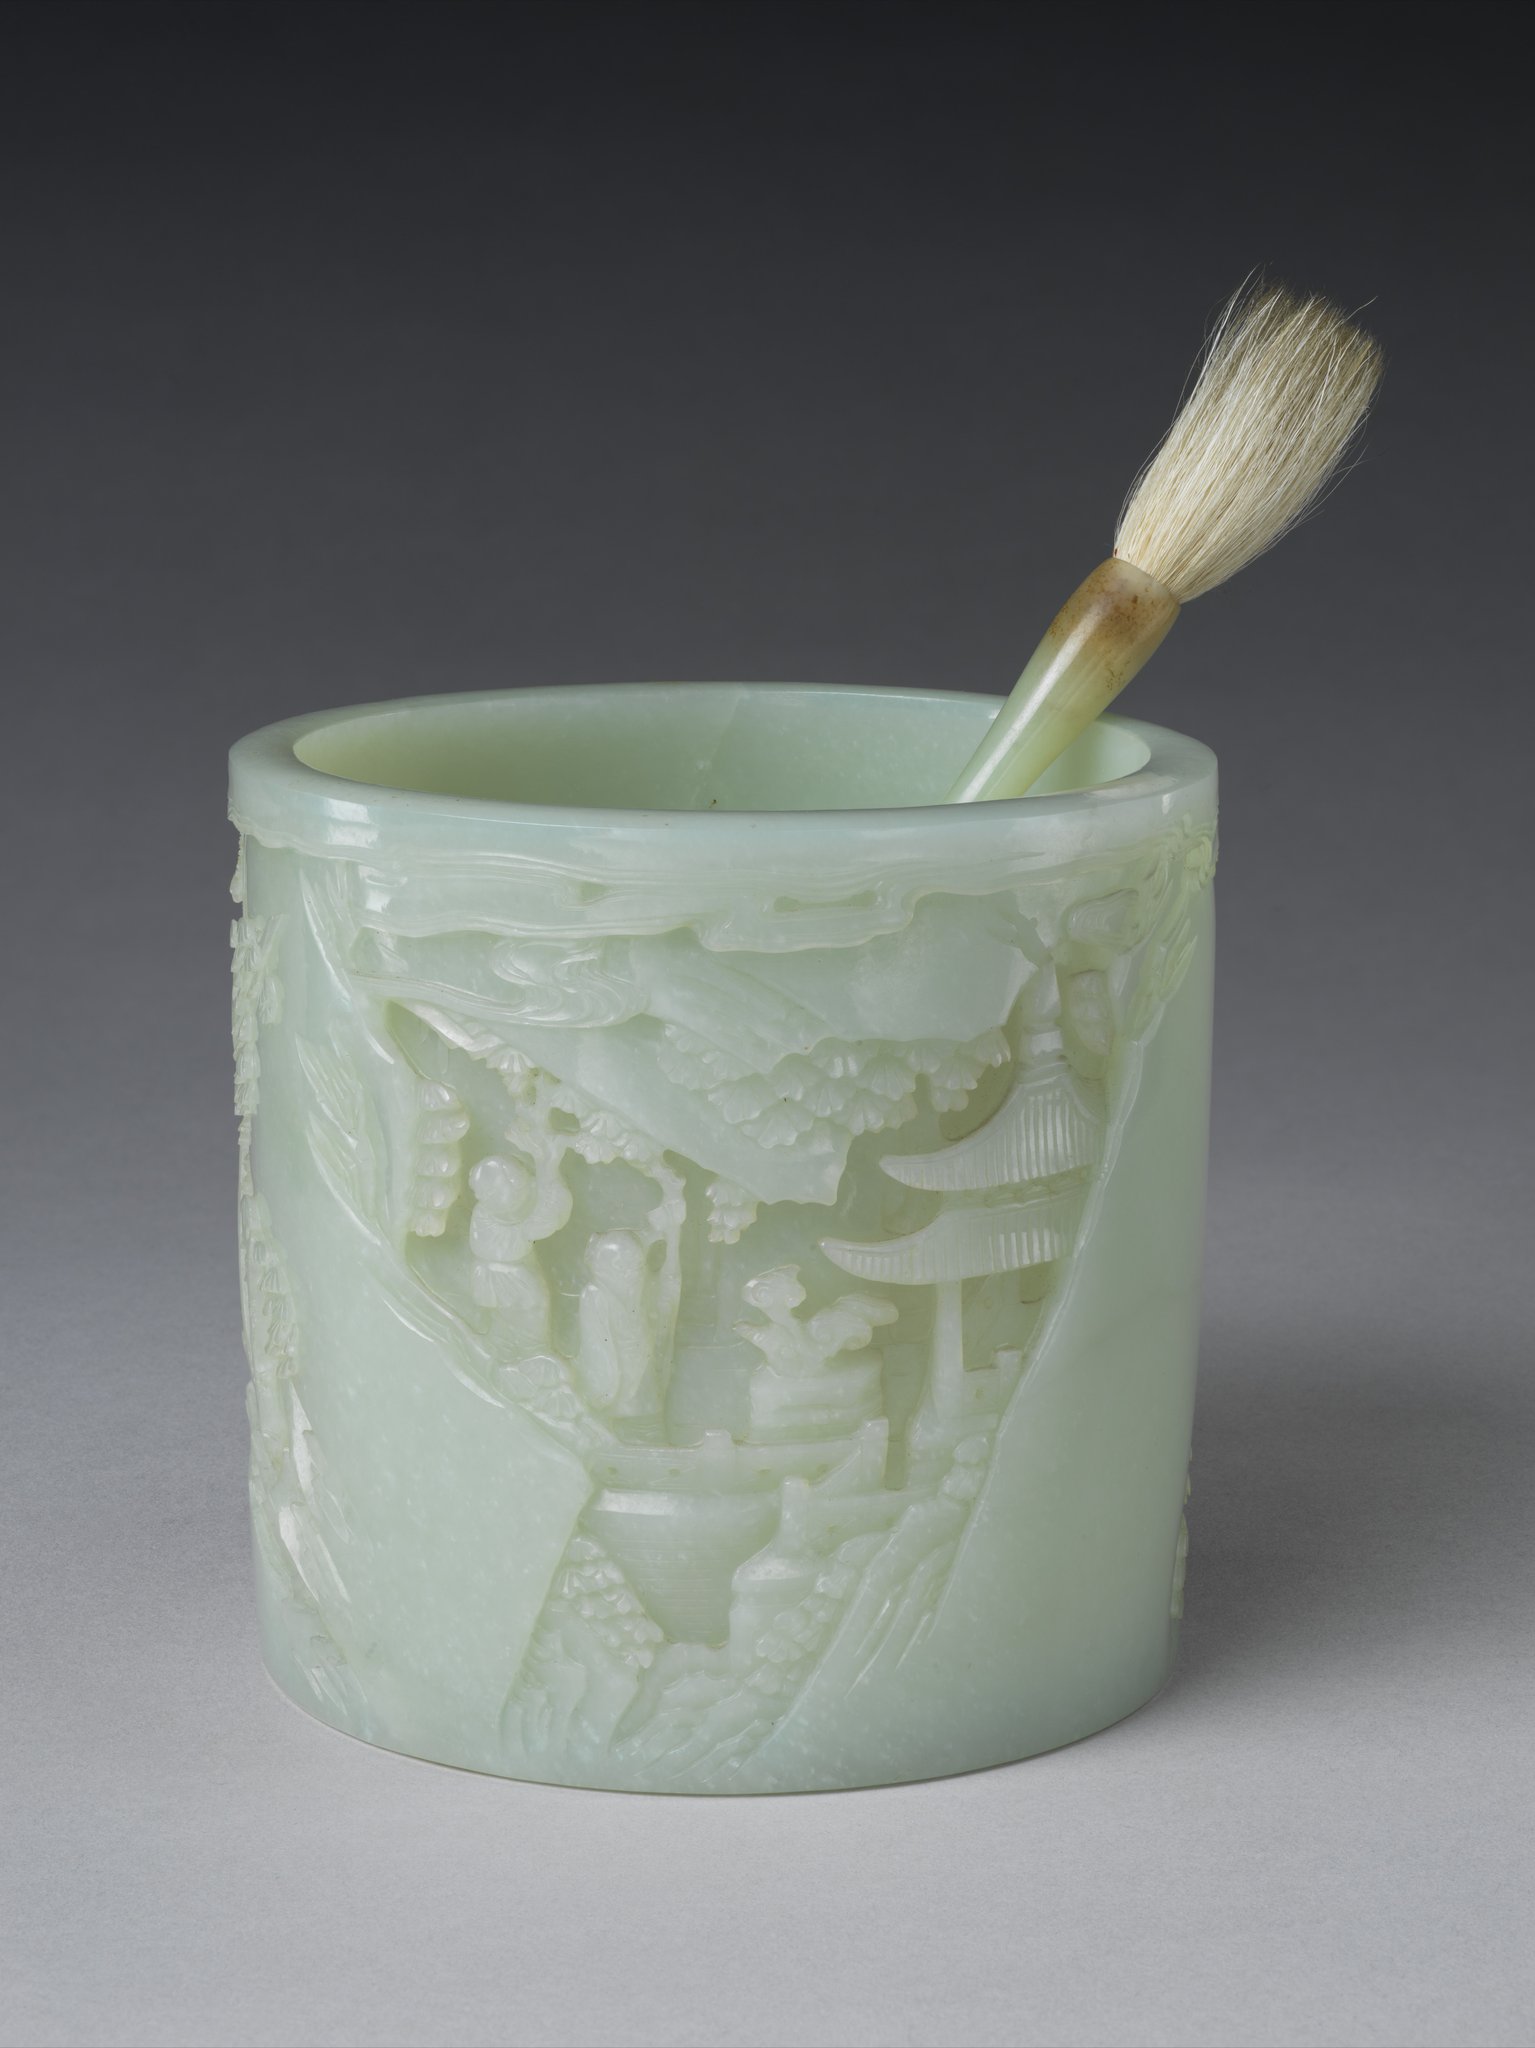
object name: brush pot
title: Brush pot with jade-handled brush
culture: chinese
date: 1736-1795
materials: jade